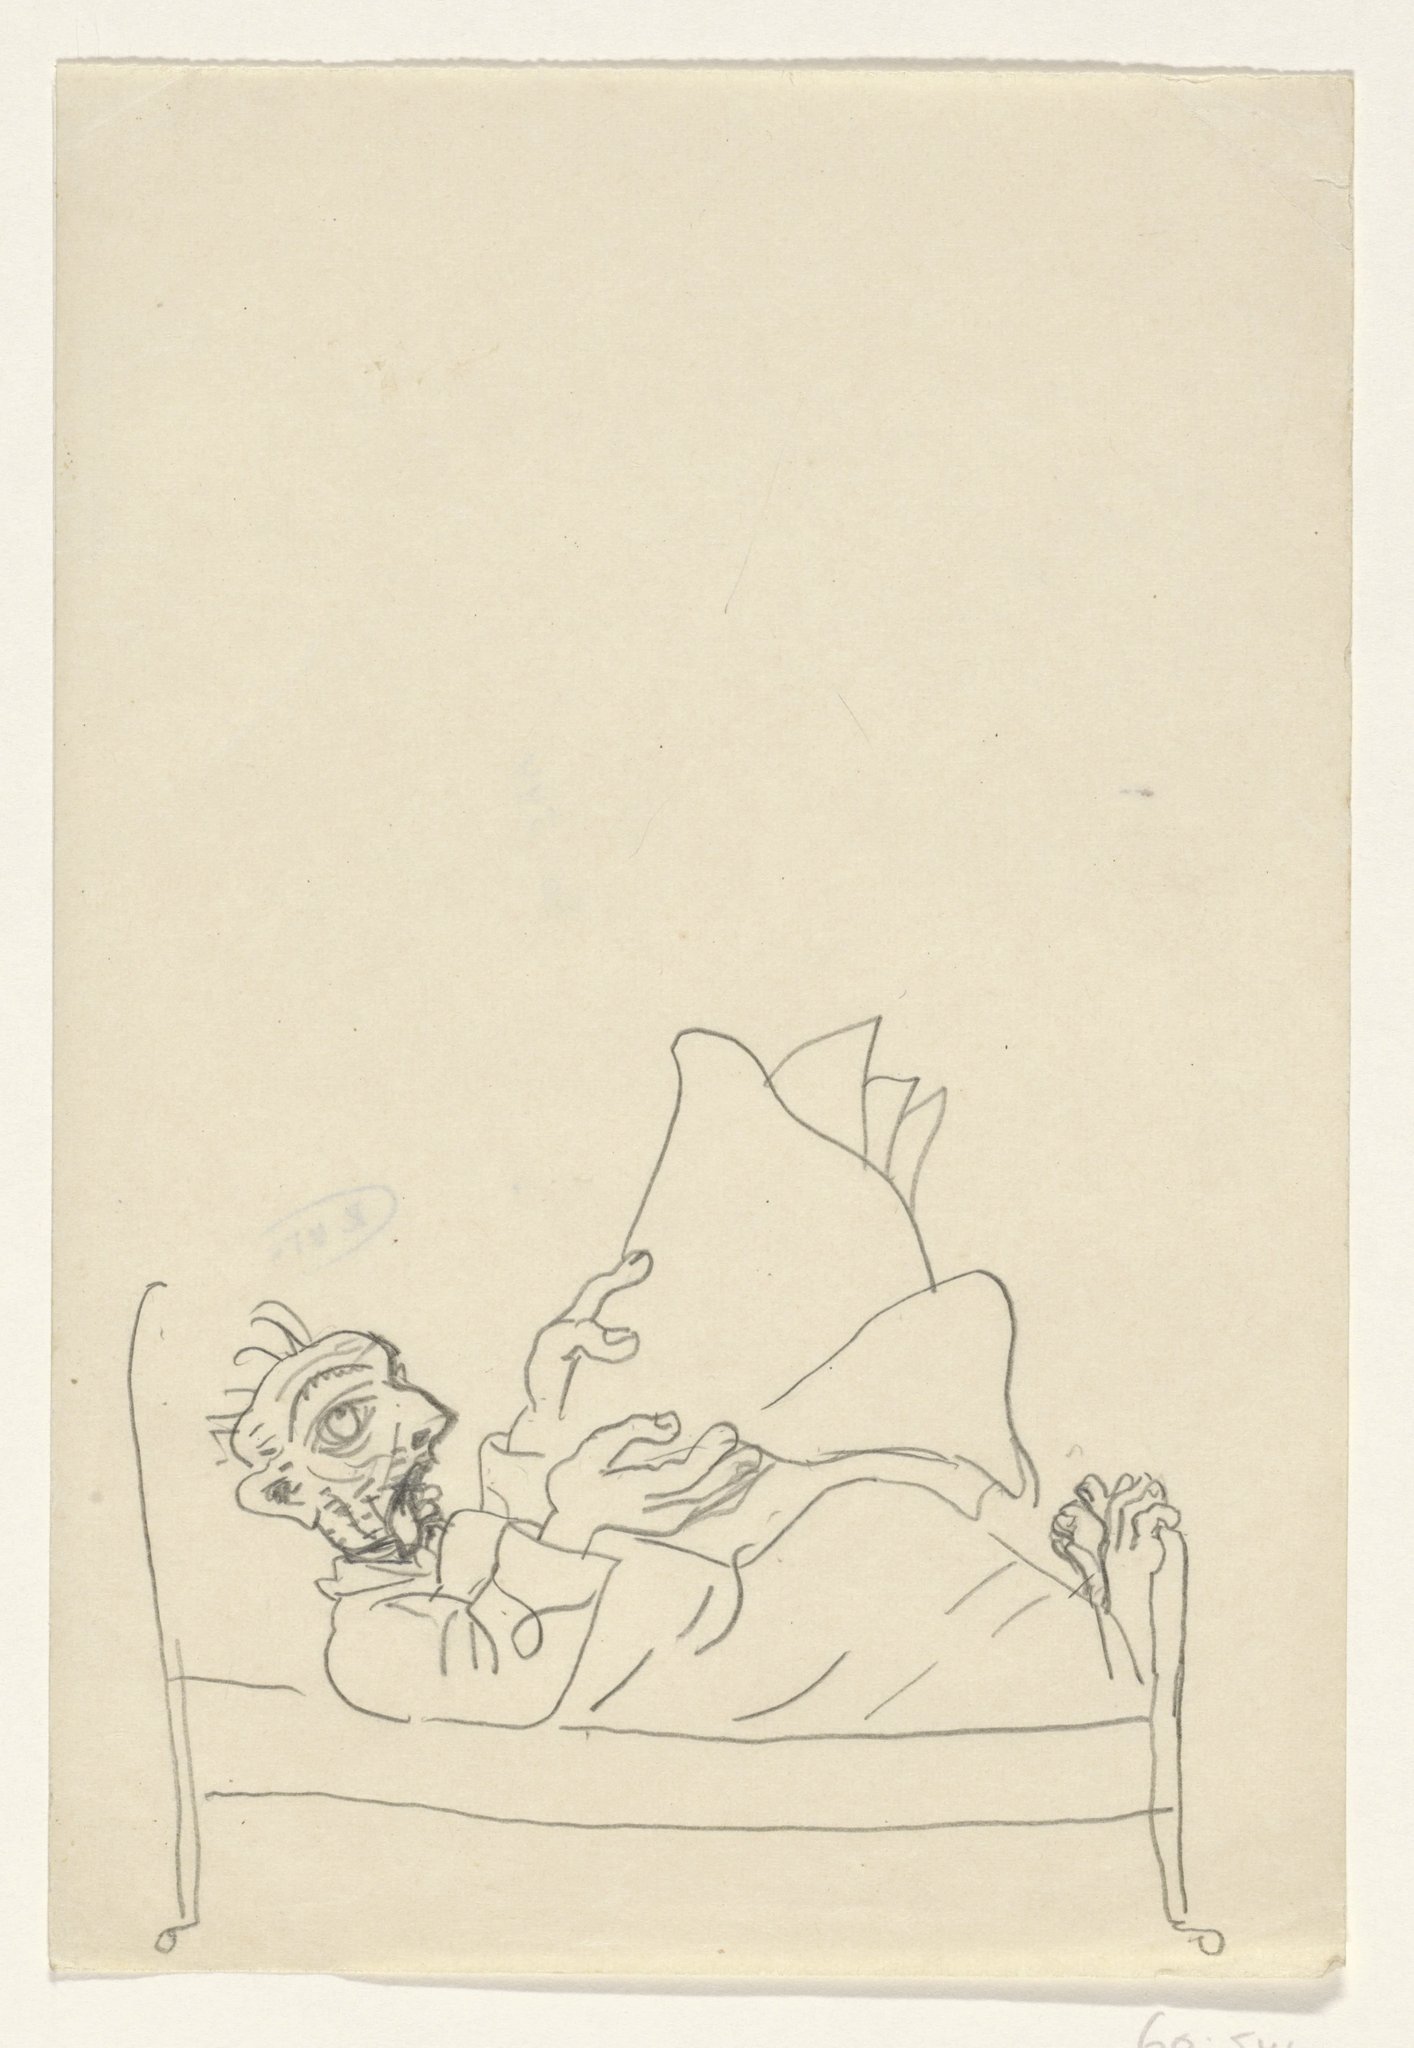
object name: drawing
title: Karikatuur van Leo Gestel op zijn ziekbed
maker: leo gestel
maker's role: draughtsman, print maker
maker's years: 1881-1941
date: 1891-1941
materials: paper, pencil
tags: draughtsman, leo gestel, sick-bed, portrait, self-portrait of artist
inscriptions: collector's mark: Lugt 2228